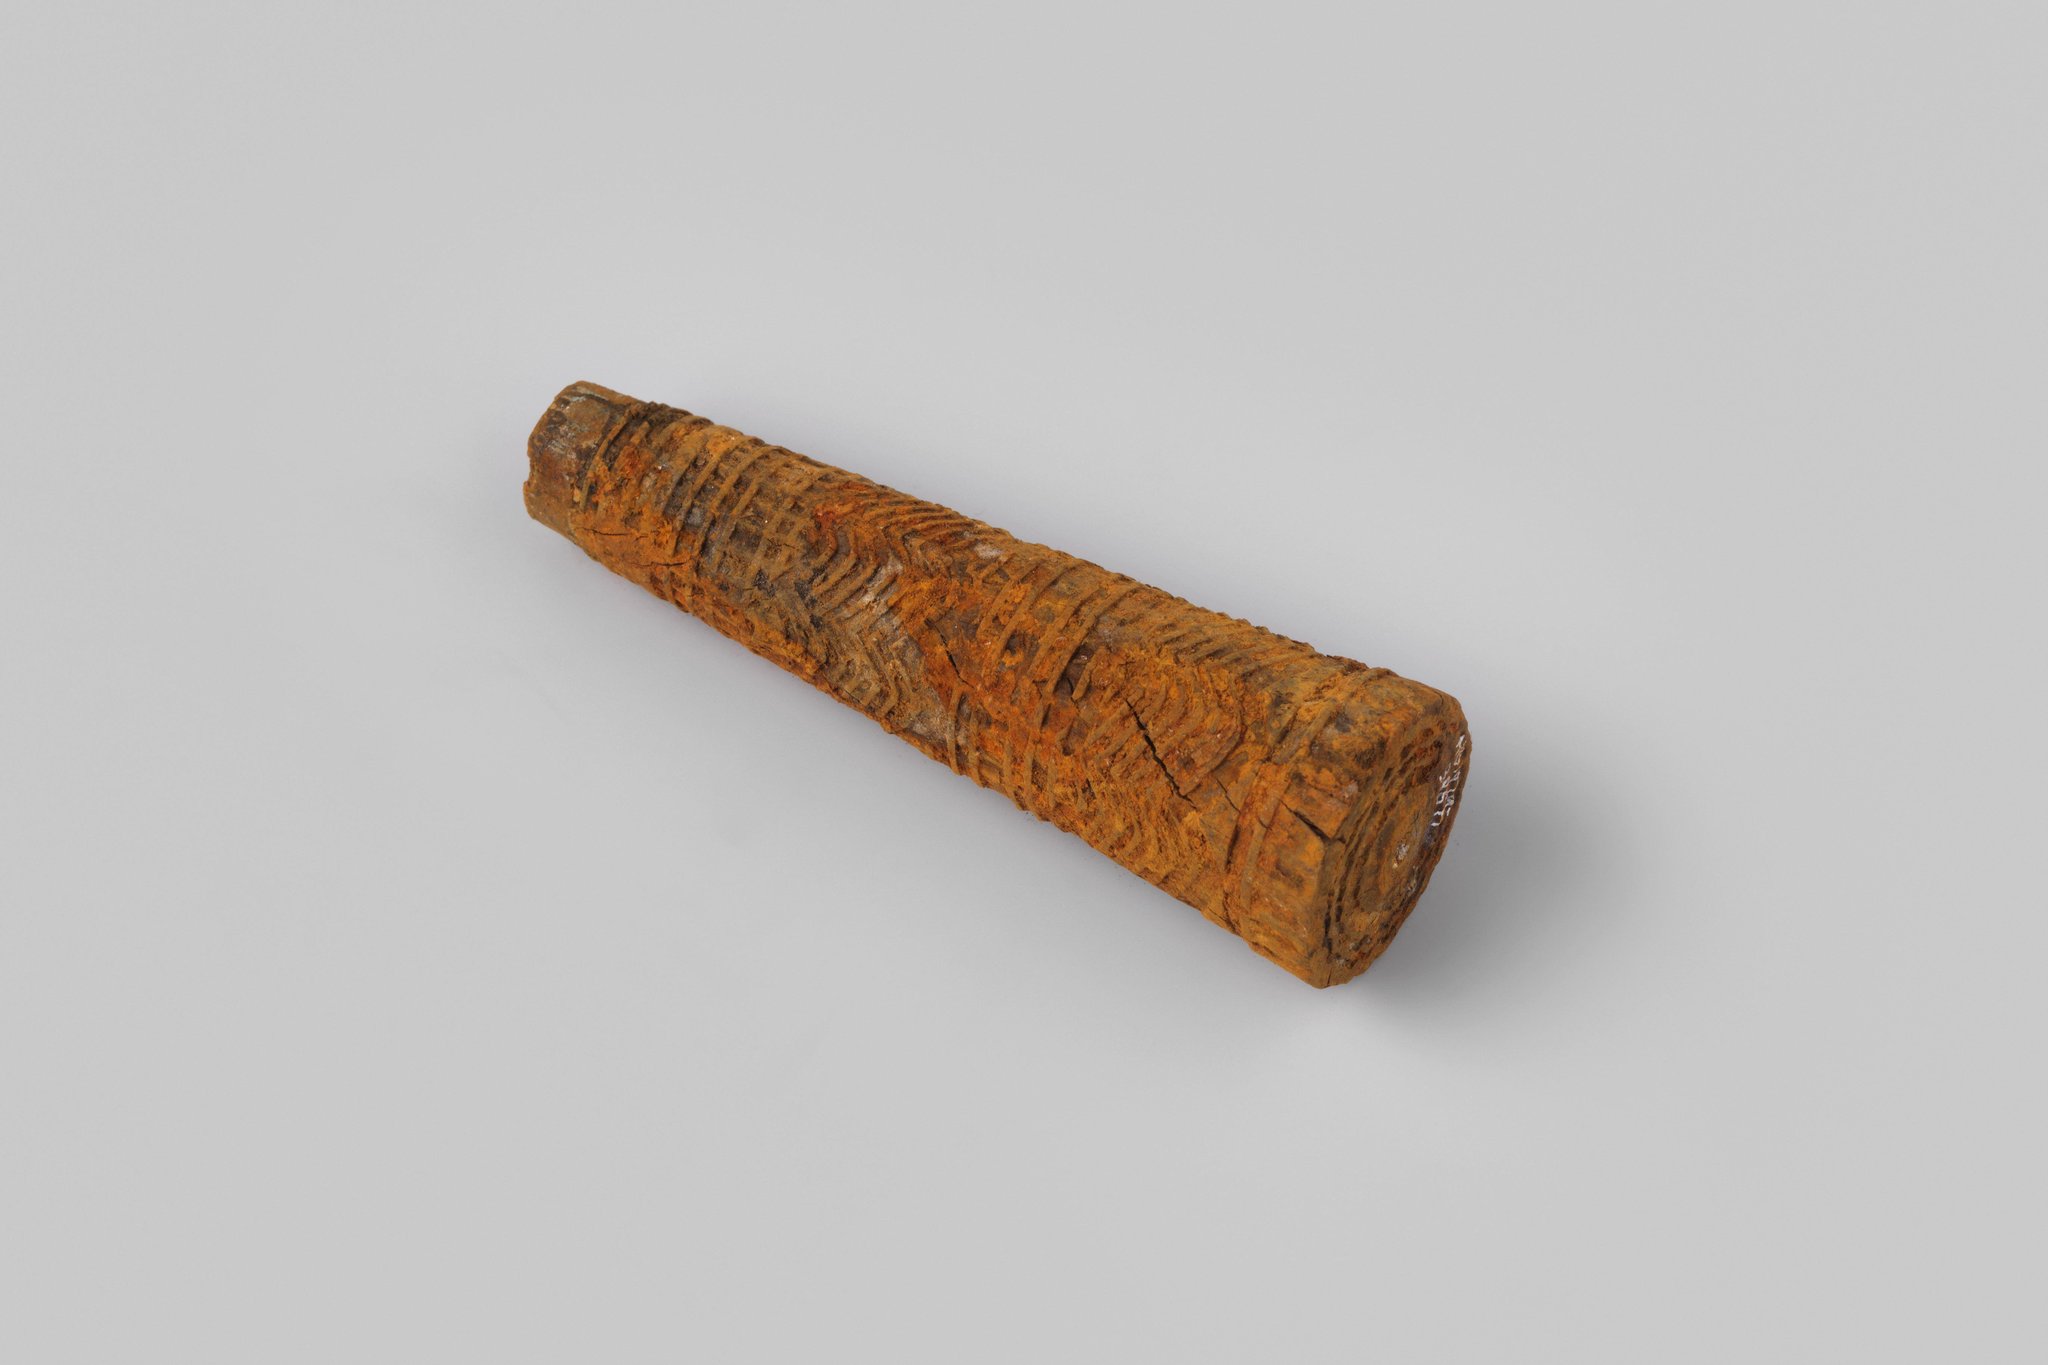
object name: knife handle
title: Messenheft uit het wrak van de Oost-Indiëvaarder Hollandia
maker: Anonymous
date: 1700-1743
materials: wood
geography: netherlands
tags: verenigde oostindische compagnie, hollandia (schip), annet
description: Knife, handle, cylindrical: tapering; id. NG 1979-403H, ferrules id. NG 1980-27H426.